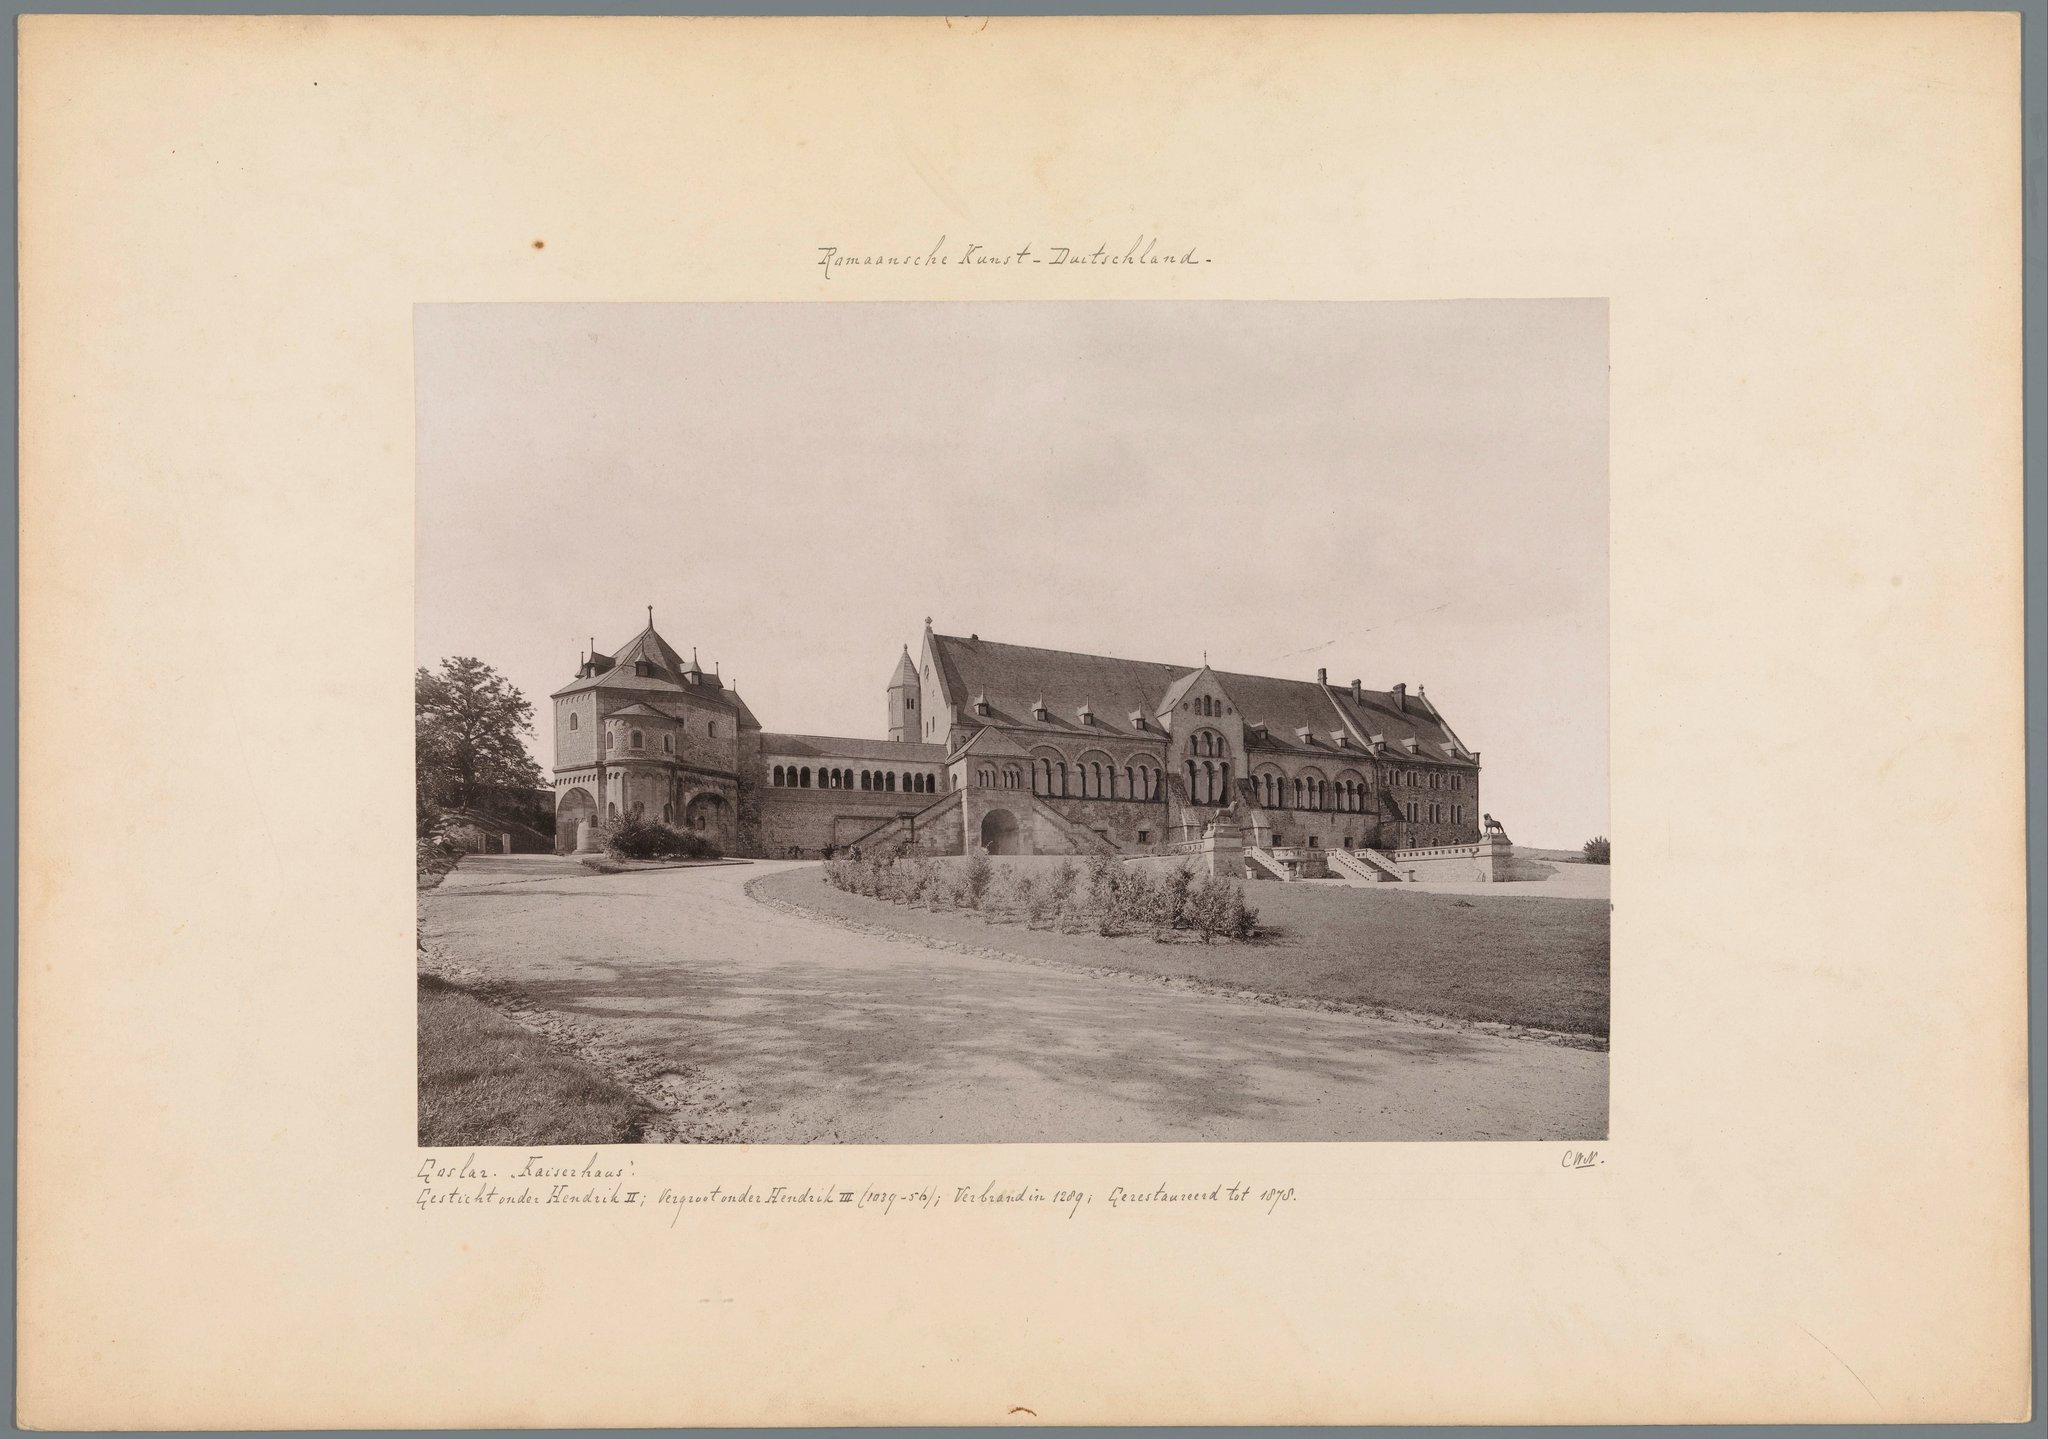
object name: photograph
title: Gezicht op de Keiserpalts te Goslar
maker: Anonymous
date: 1875-1900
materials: cardboard, paper, ink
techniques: photograph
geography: goslar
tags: palace, exterior ~ representation of a building, façade (of house or building)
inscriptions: collector's mark: ‘KUNSTNIJVERHEIDSCHOOL QUELLINUS AMSTERDAM FRANS HALSSTRAAT 14.’, inscription: ‘CWN.’, inscription: ‘Romaansche Kunst - Duitschland. Goslar. (...) Gerestaureerd tot 1878.’, collector's mark: ‘INSTITUUT VOOR KUNST- NIJVERHEIDSONDERWIJS GABRIËL METSUSTRAAT No. 16. AMSTERDAM’